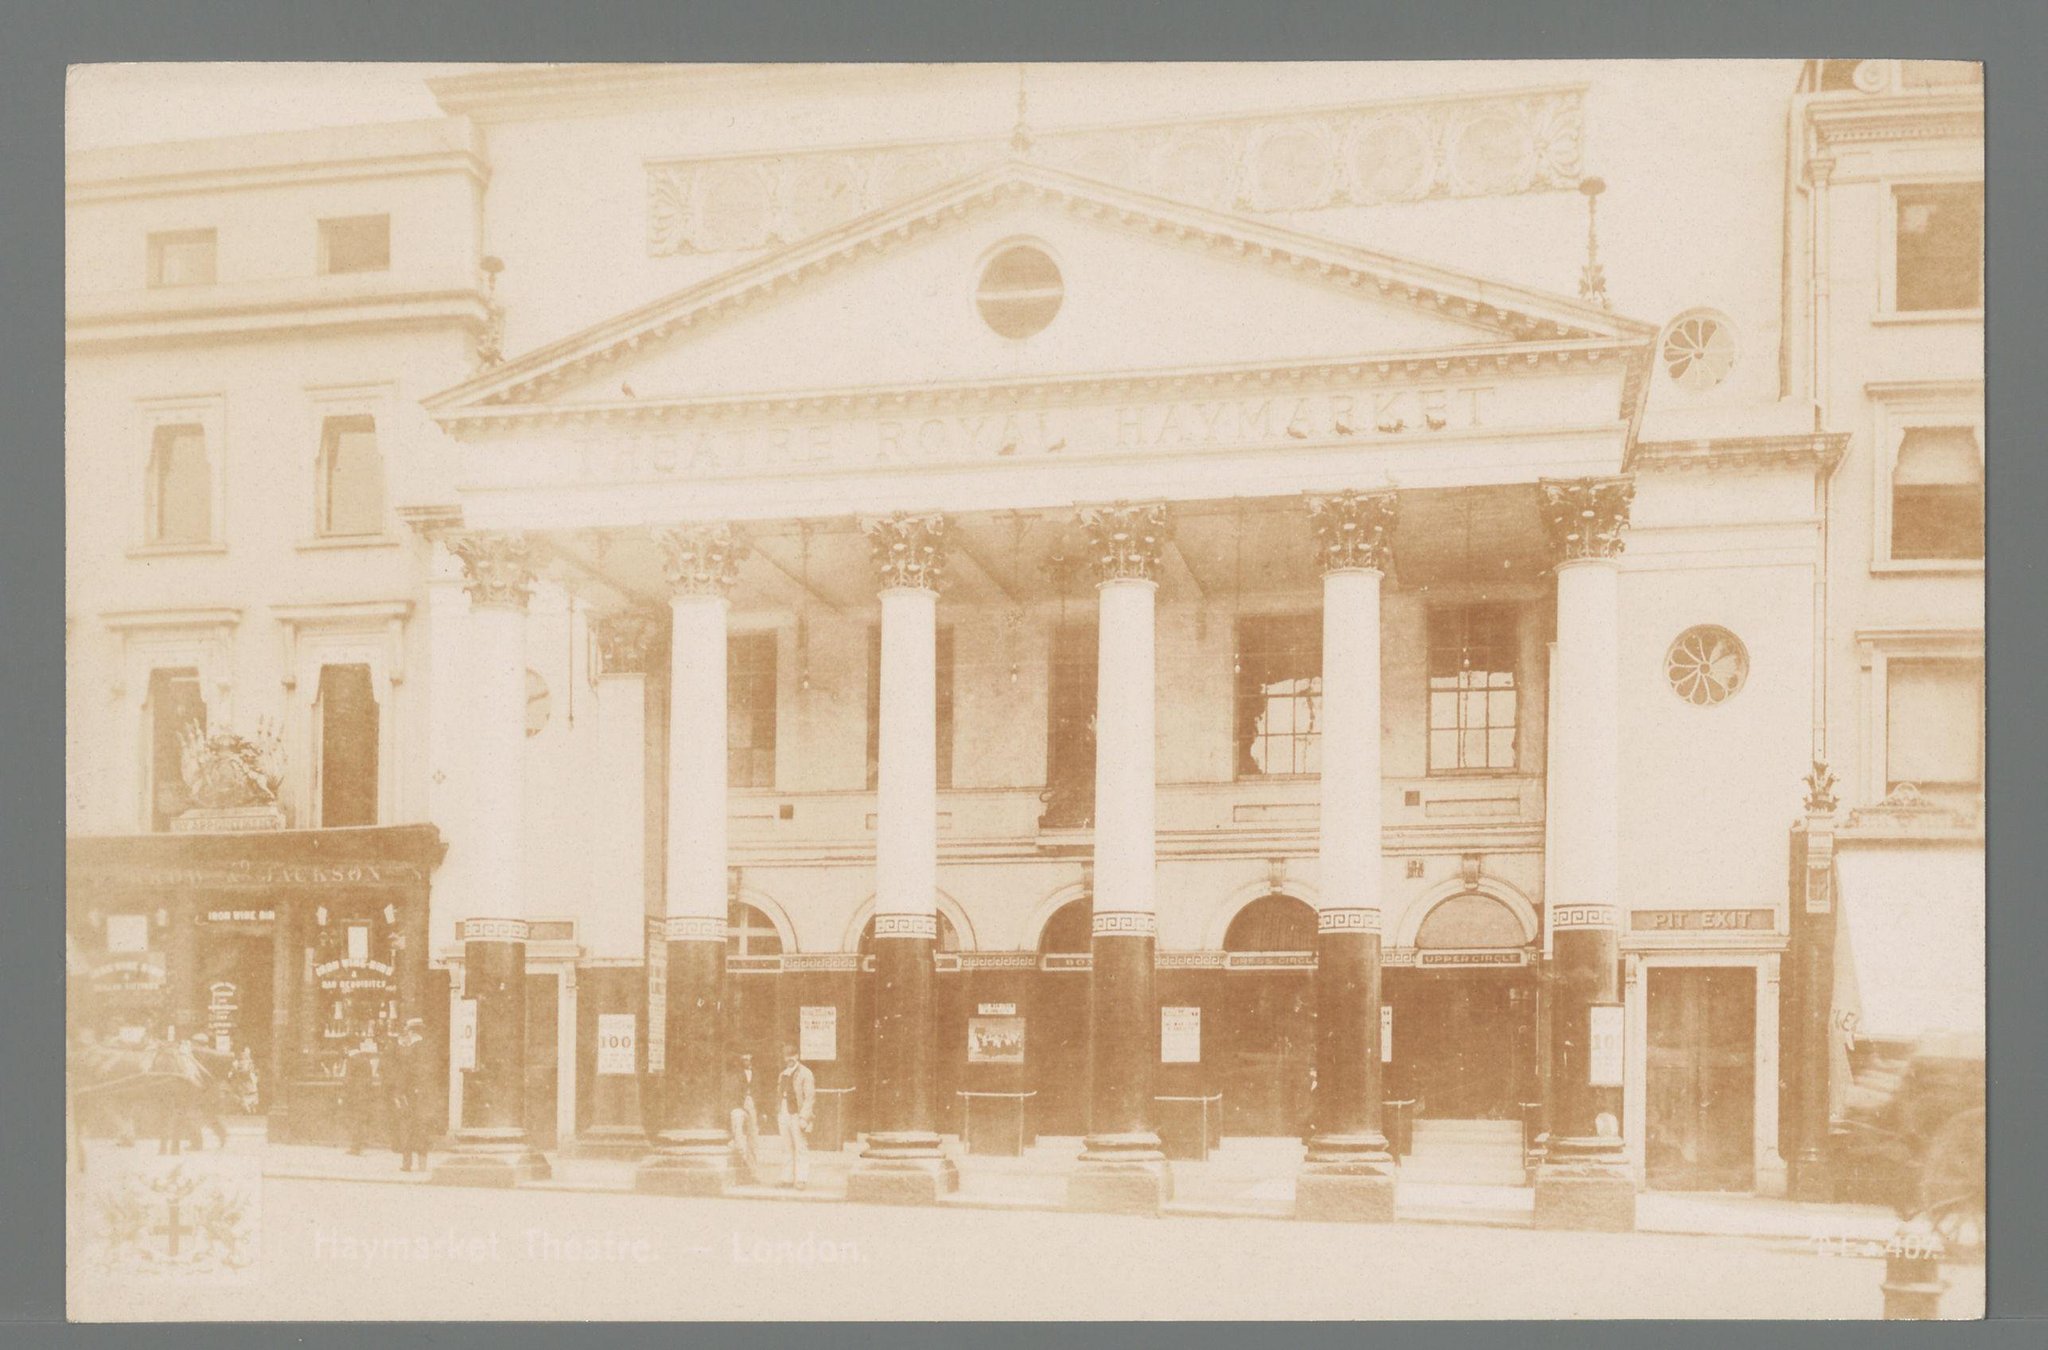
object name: photograph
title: AL Series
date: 1902-1940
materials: paper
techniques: gelatin silver print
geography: london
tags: coat of arms (as symbol of the state, etc.), theatre (building)